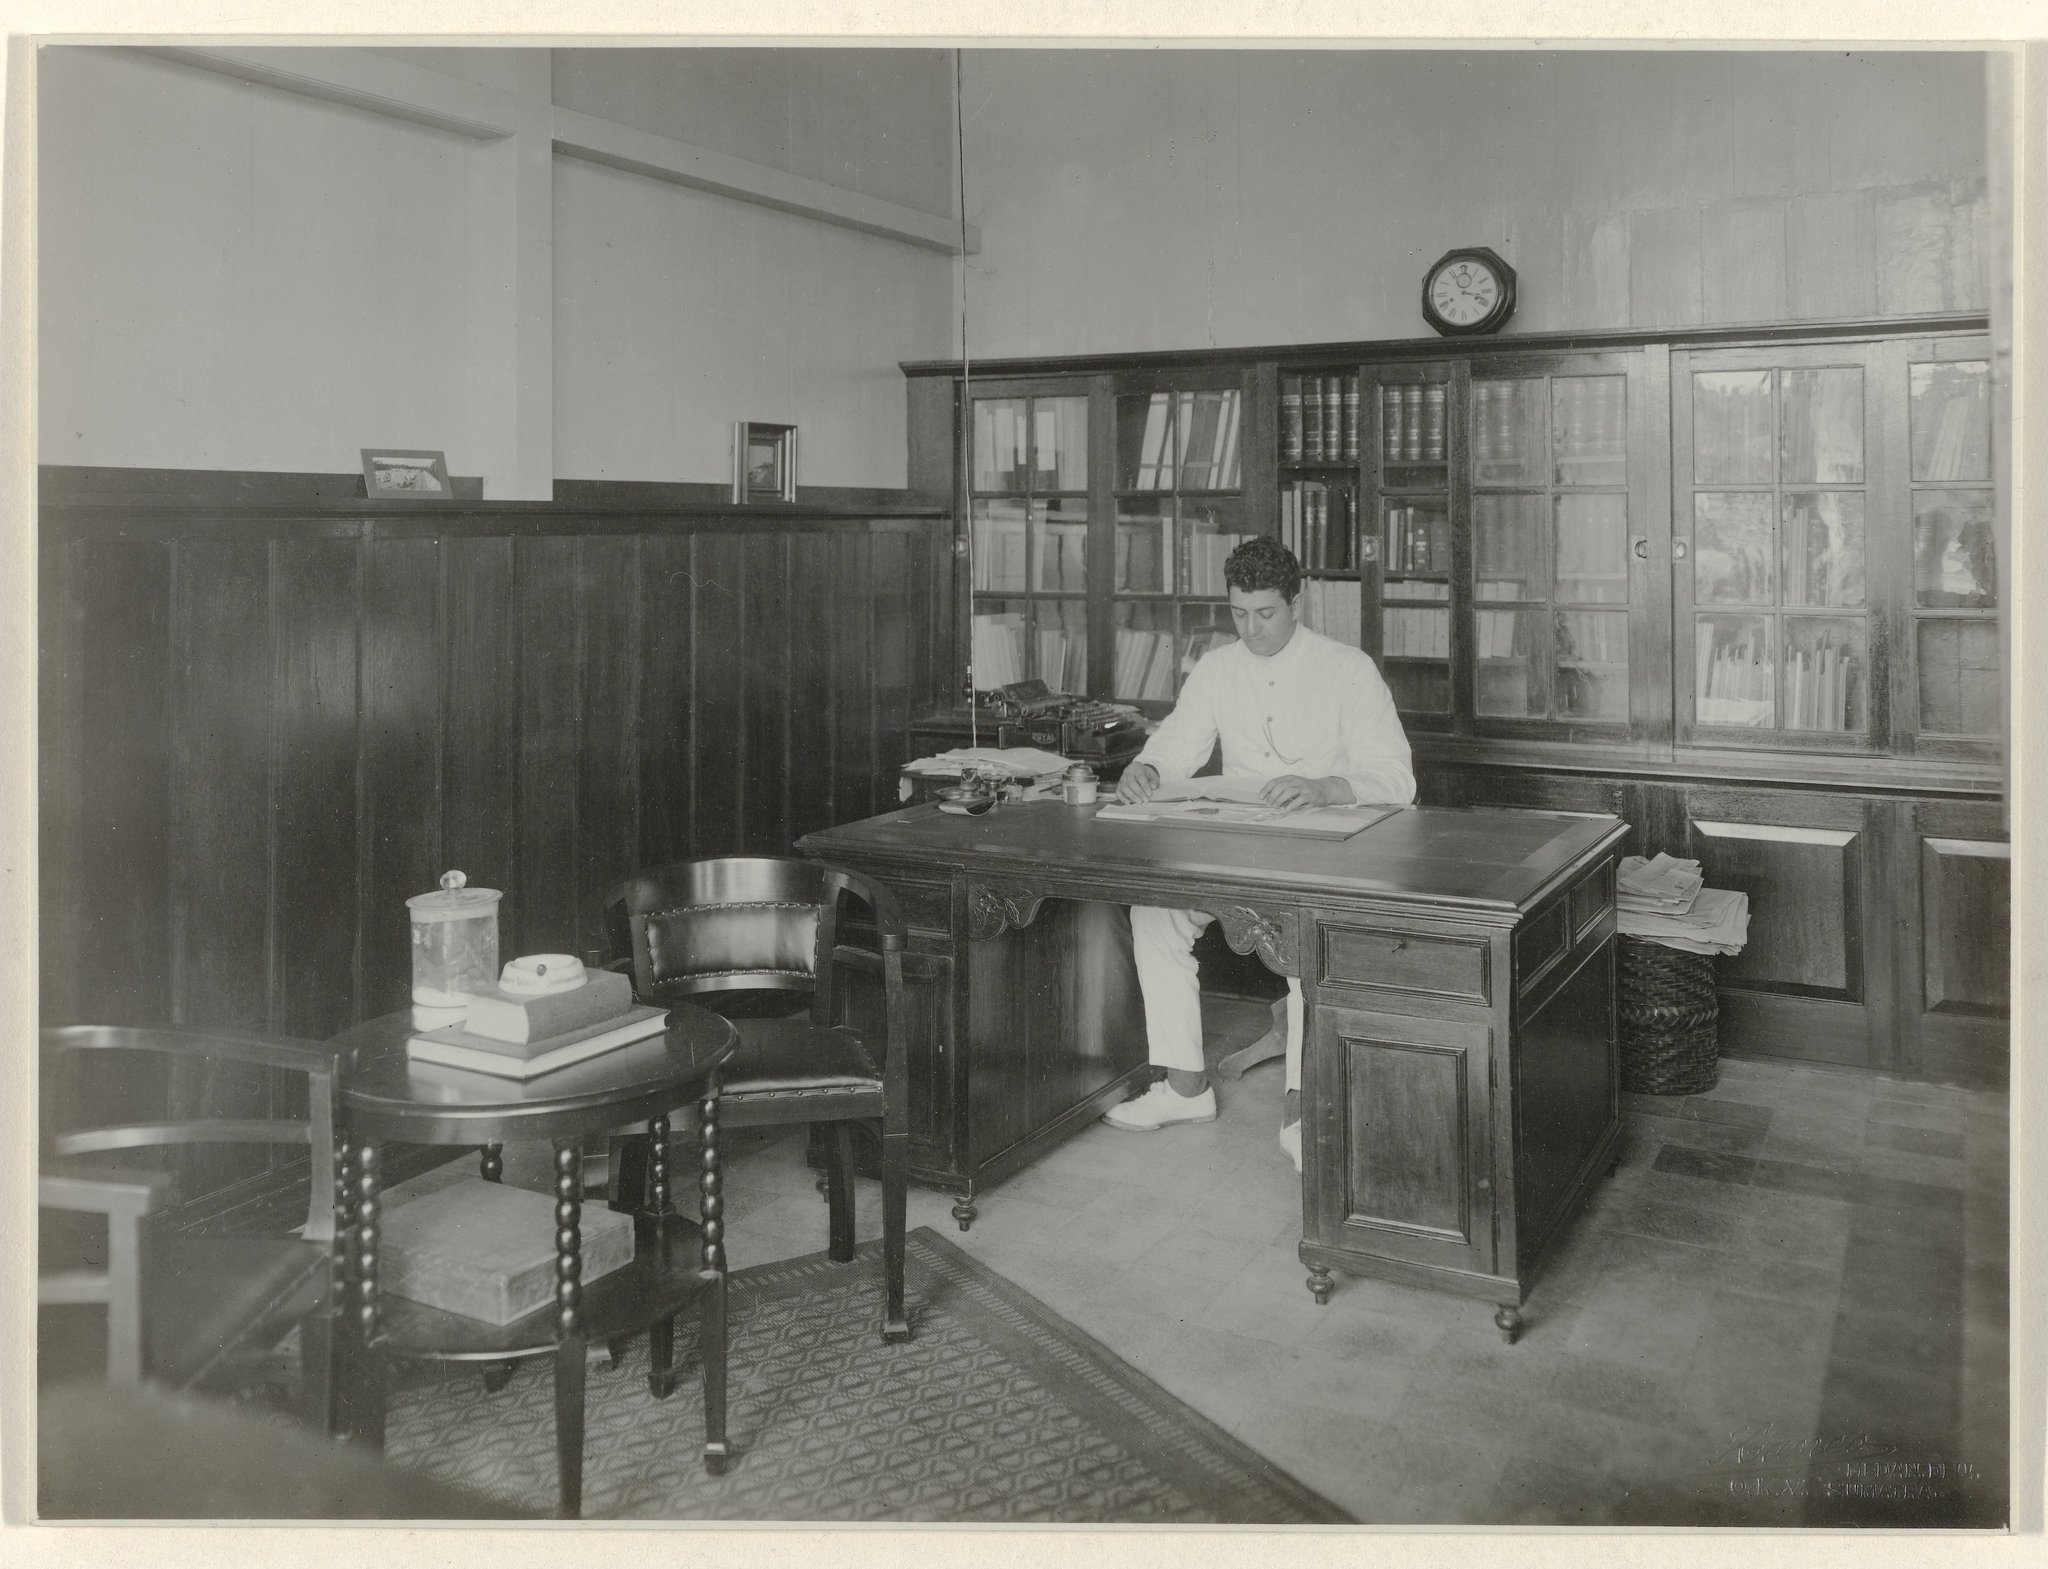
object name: photograph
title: Kantoor van de hoofdredacteur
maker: t. kaneo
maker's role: fotograaf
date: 1921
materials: photographic support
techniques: gelatin silver print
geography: medan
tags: dutch east indies, the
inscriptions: inscription: ‘Privé Kantoor Hoofd Redacteur’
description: De hoofdredacteur van de Deli Courant zittend achter een bureau in zijn privékantoor. Onderdeel van een groep van 18 foto's uit 1921 binnen de groep van 49 losse zwart-wit foto's van verschillend formaat over de uitgeverij en drukkerij van de krant Deli Courant in Medan in de periode 1885-1947.